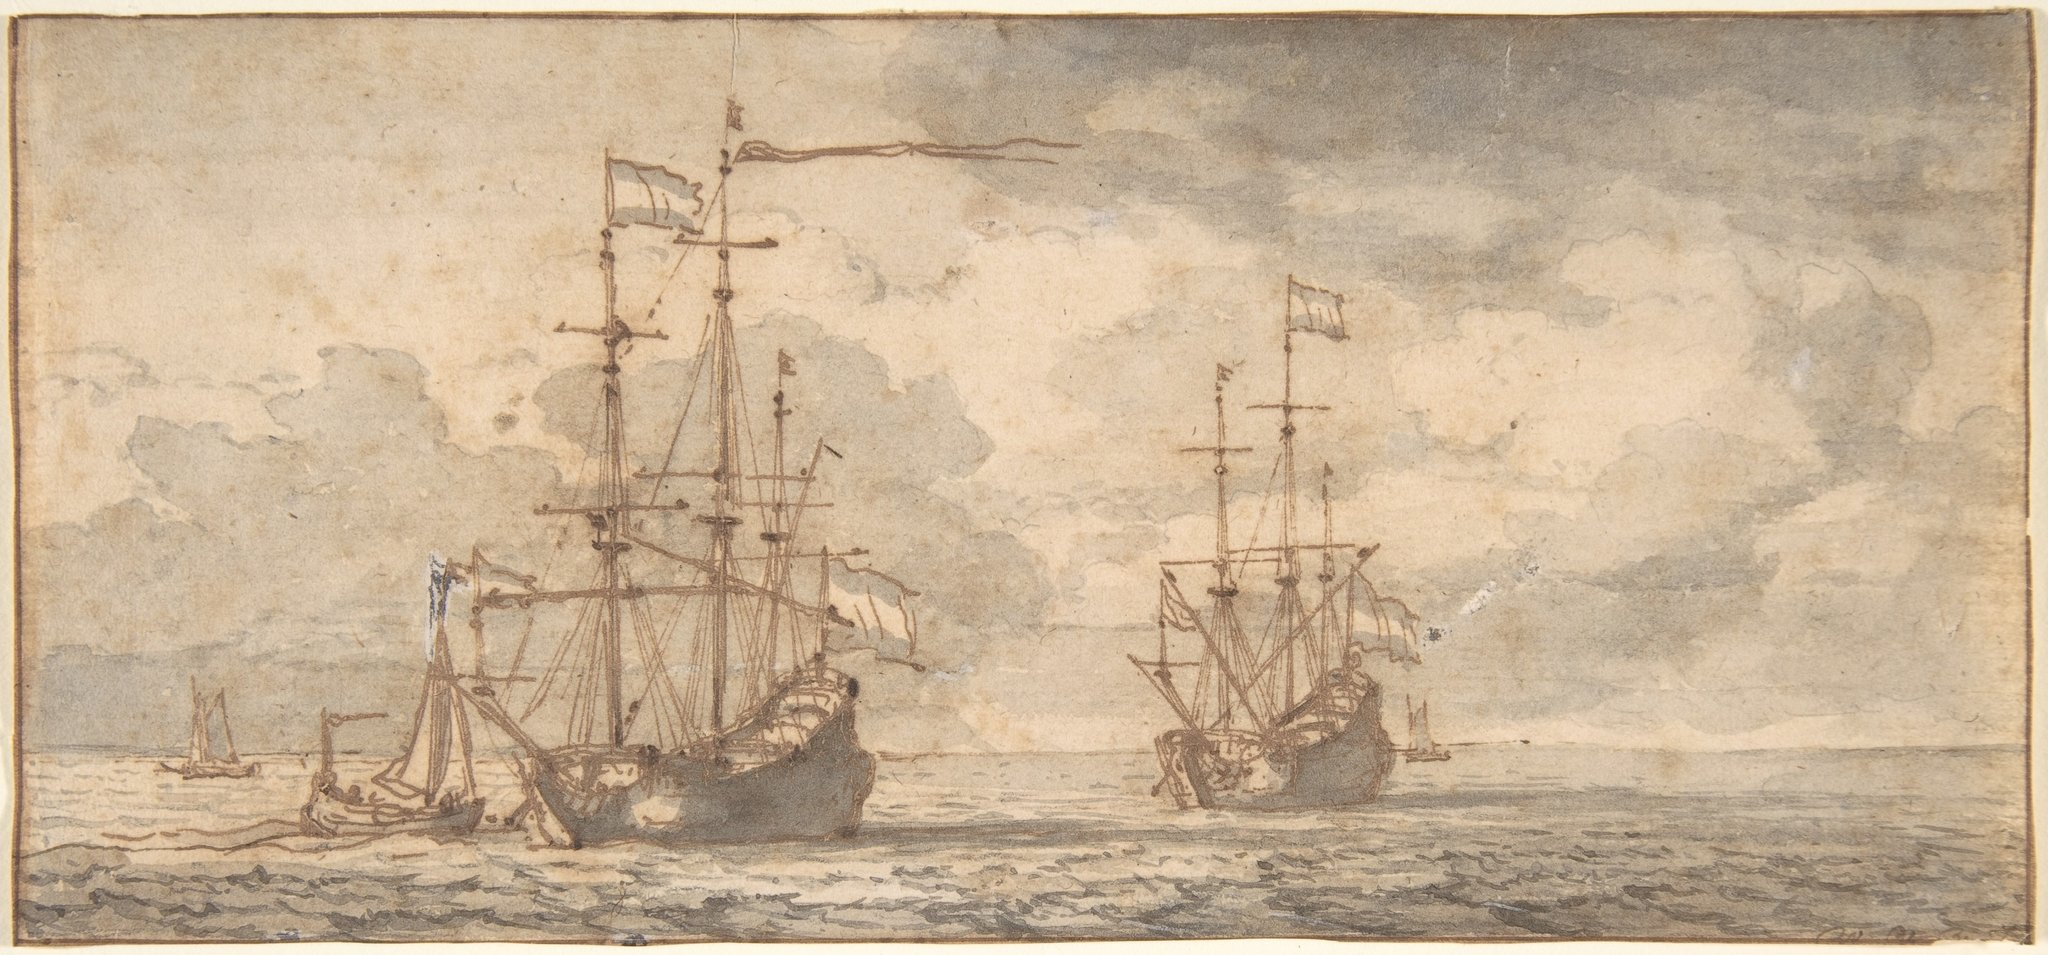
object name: drawing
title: Dutch Ships at Anchor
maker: willem van de velde (ii)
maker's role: artist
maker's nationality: dutch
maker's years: 1633-1707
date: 1634-1733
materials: chalk, ink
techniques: brush, pen, wash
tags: ships